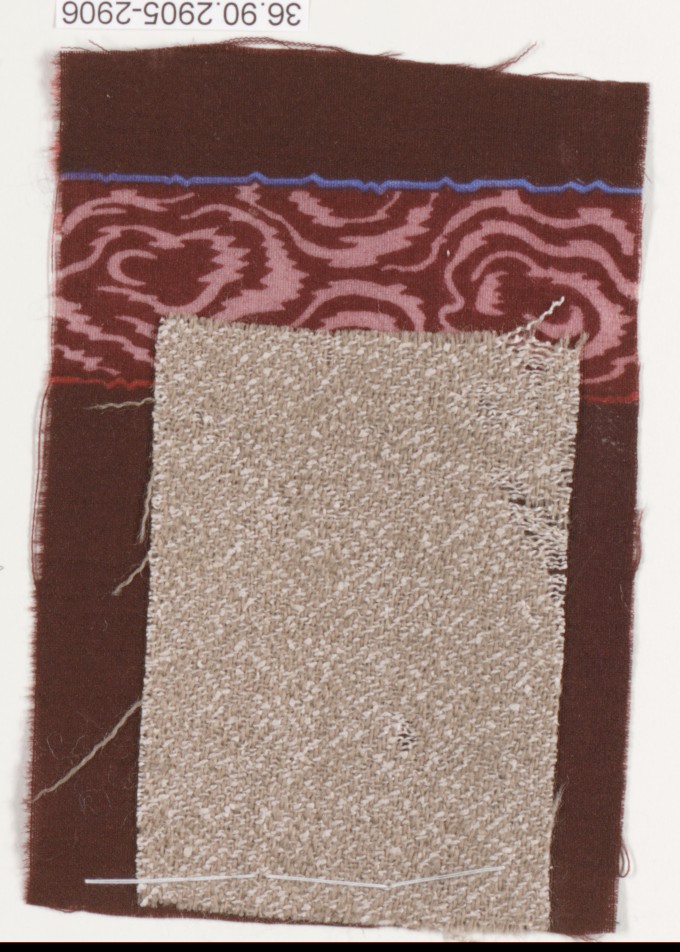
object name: piece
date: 1801-1900